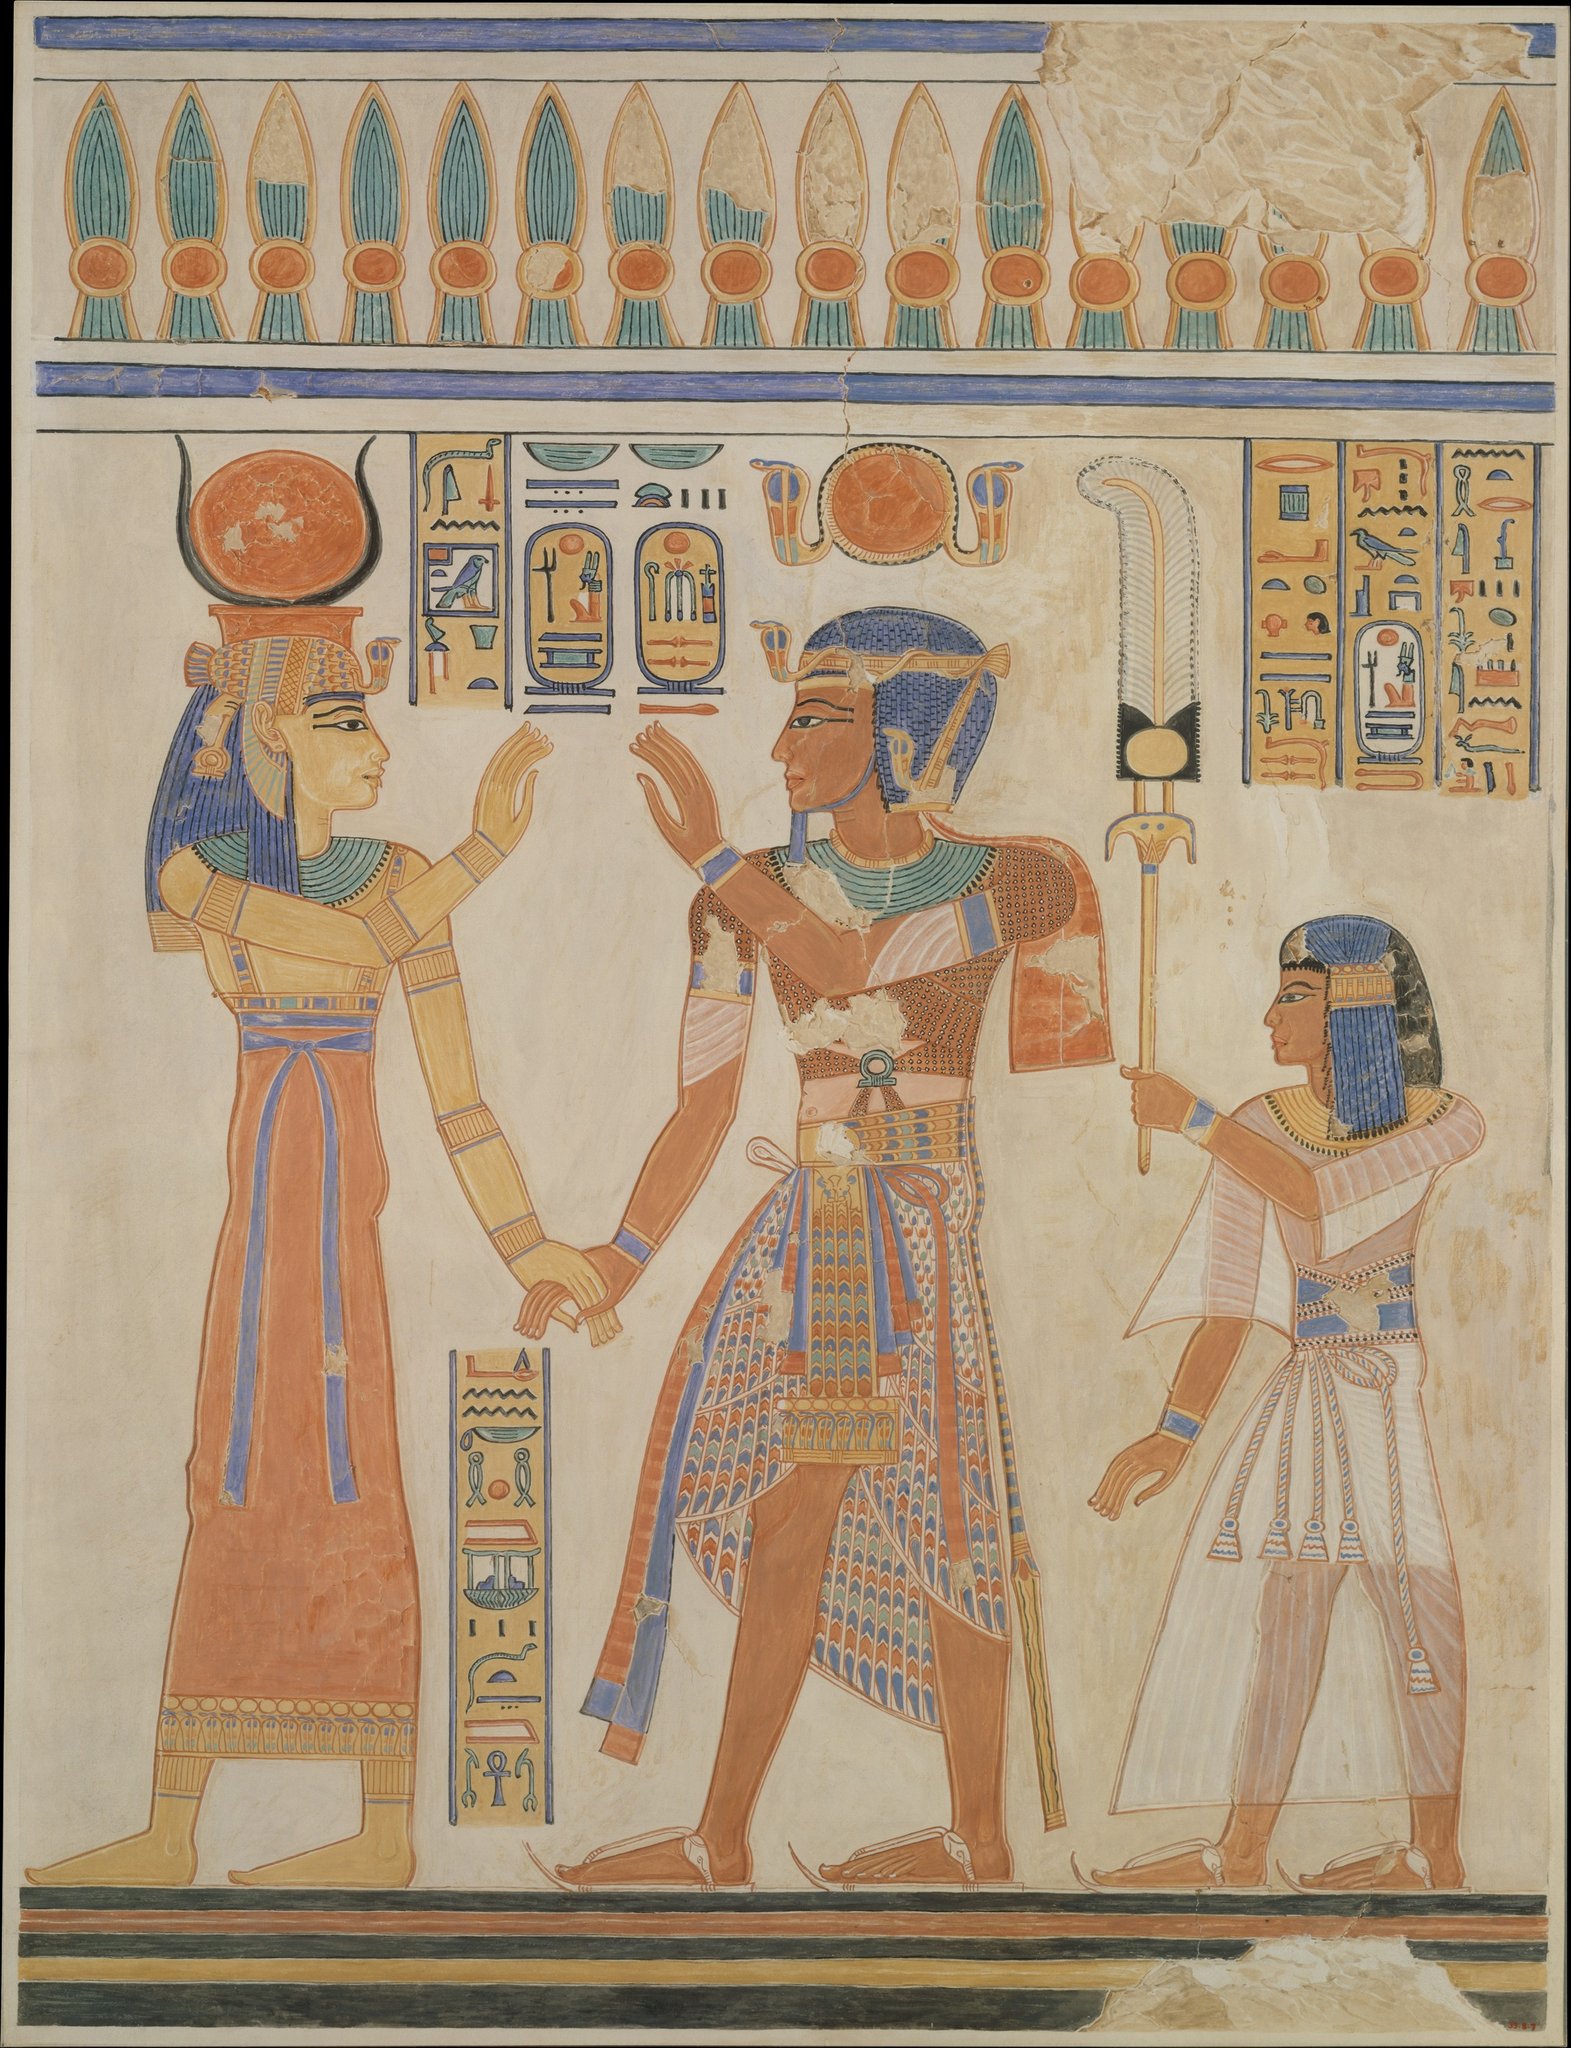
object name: facsimile, amenherkhepeshef qv 55, ramesses iii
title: Ramesses III and Prince Amenherkhepeshef before Hathor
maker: nina de garis davies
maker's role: artist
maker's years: 1881-1965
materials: ink, paint, paper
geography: egypt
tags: kings,princes,men,hieroglyphs,hathor